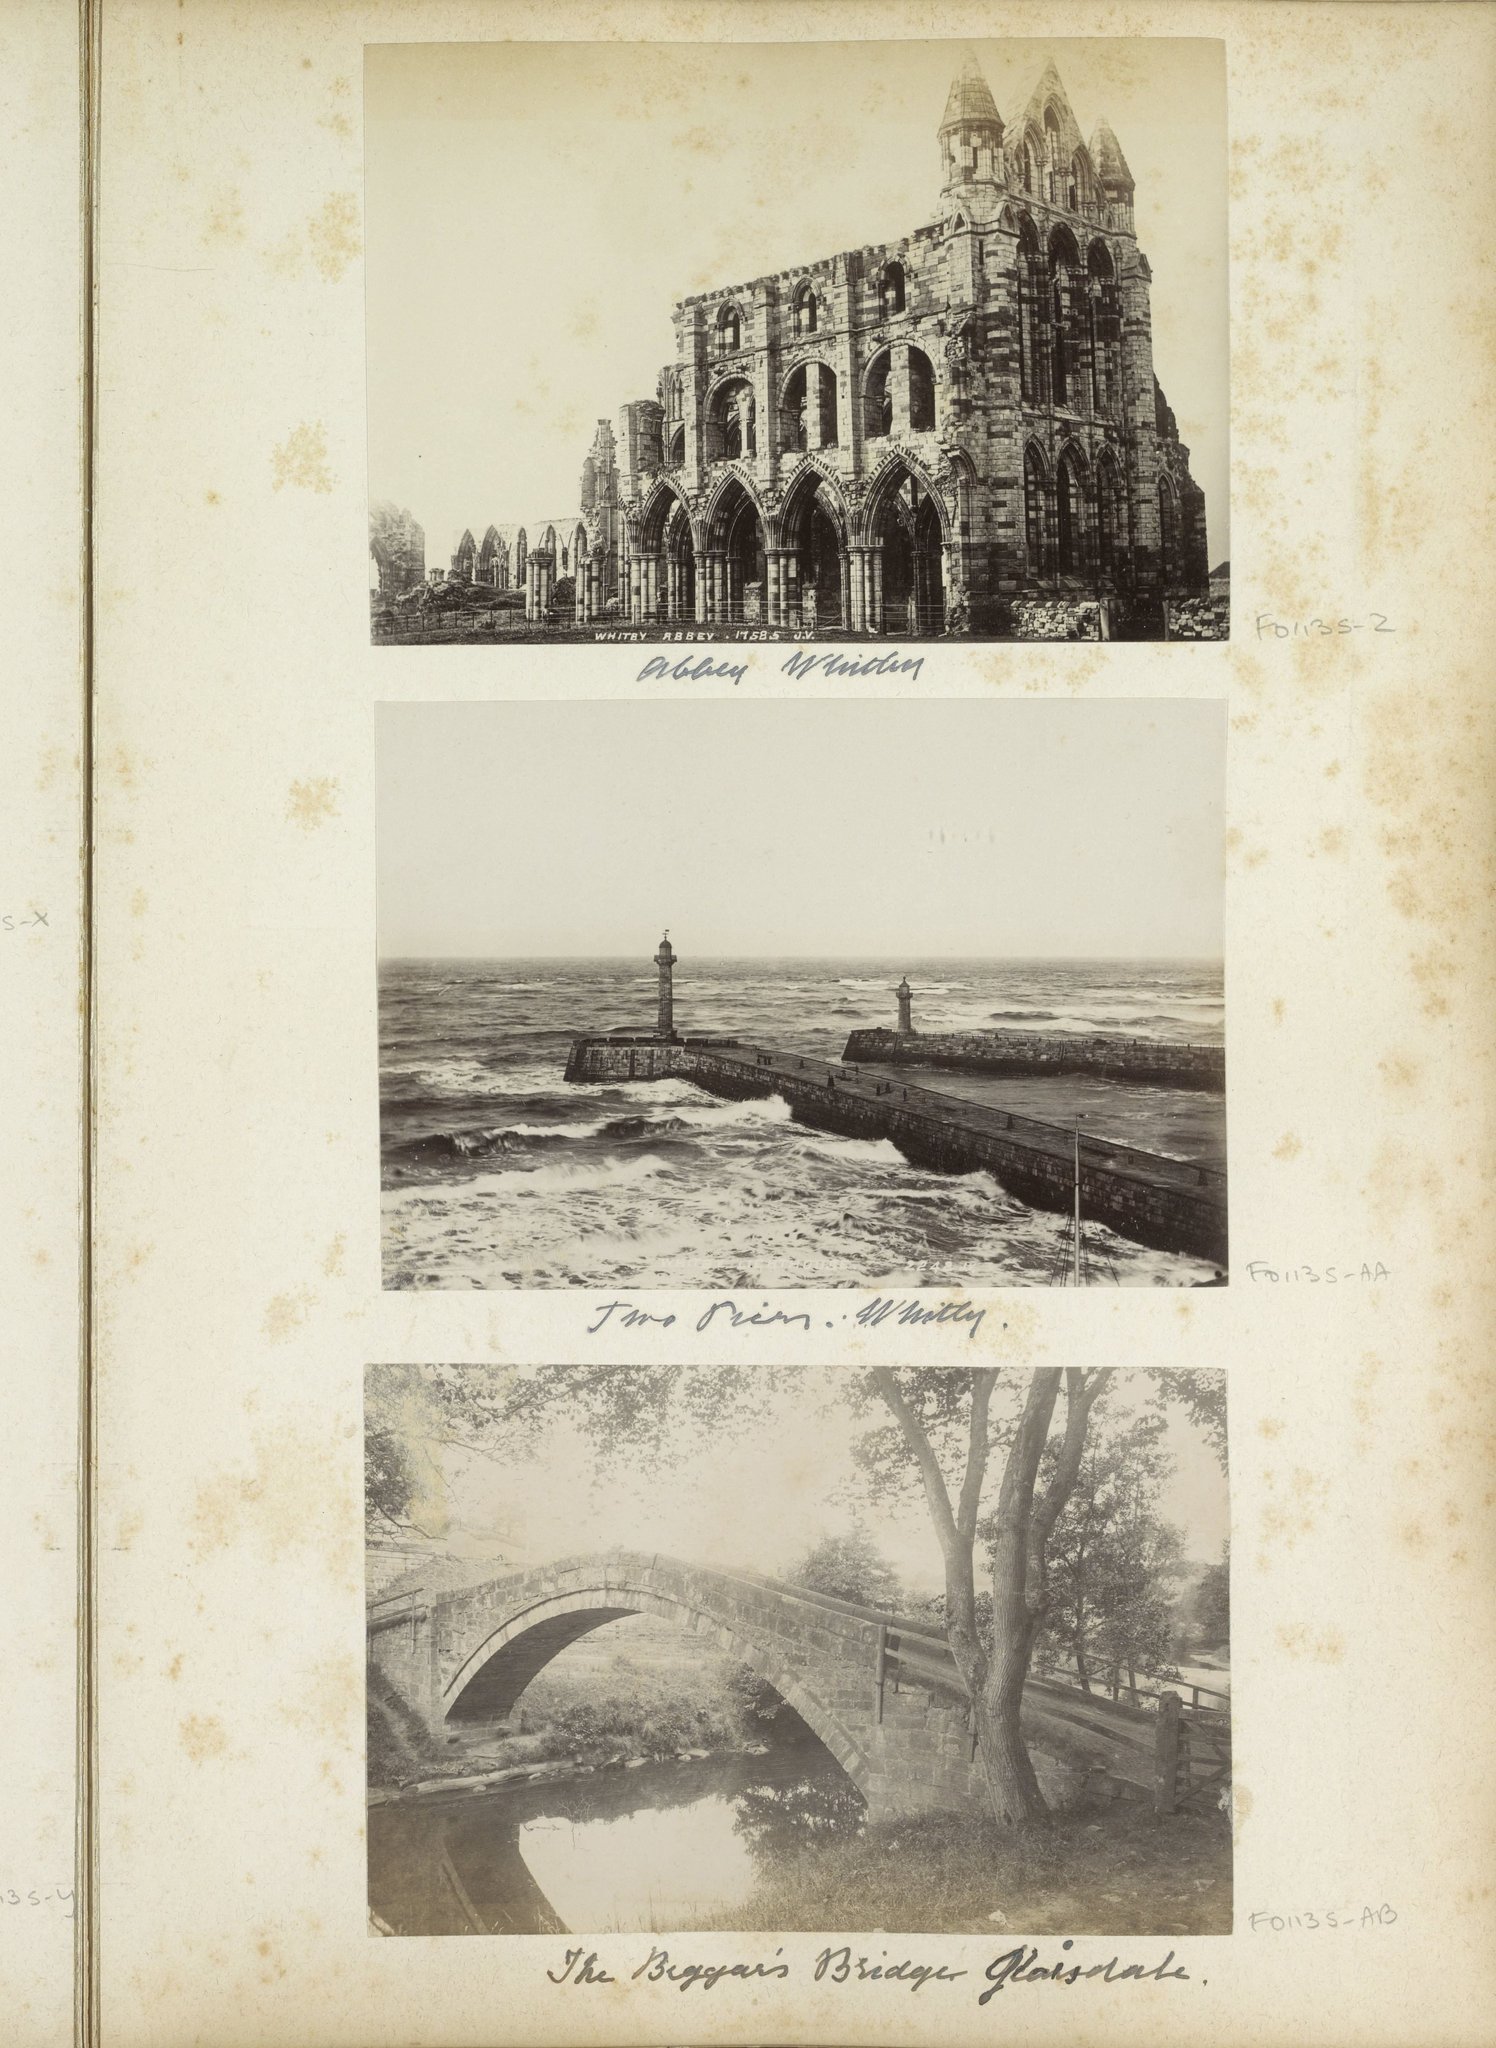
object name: photograph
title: Whitby Abbey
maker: james valentine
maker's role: fotograaf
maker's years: 1815-1880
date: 1898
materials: paper, photographic support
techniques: albumen print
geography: whitby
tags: ruin of a dwelling, house, castle, etc.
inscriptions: negative number: ‘17585’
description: Onderdeel van Reisalbum met foto's van bezienswaardigheden in Engeland en Frankrijk.